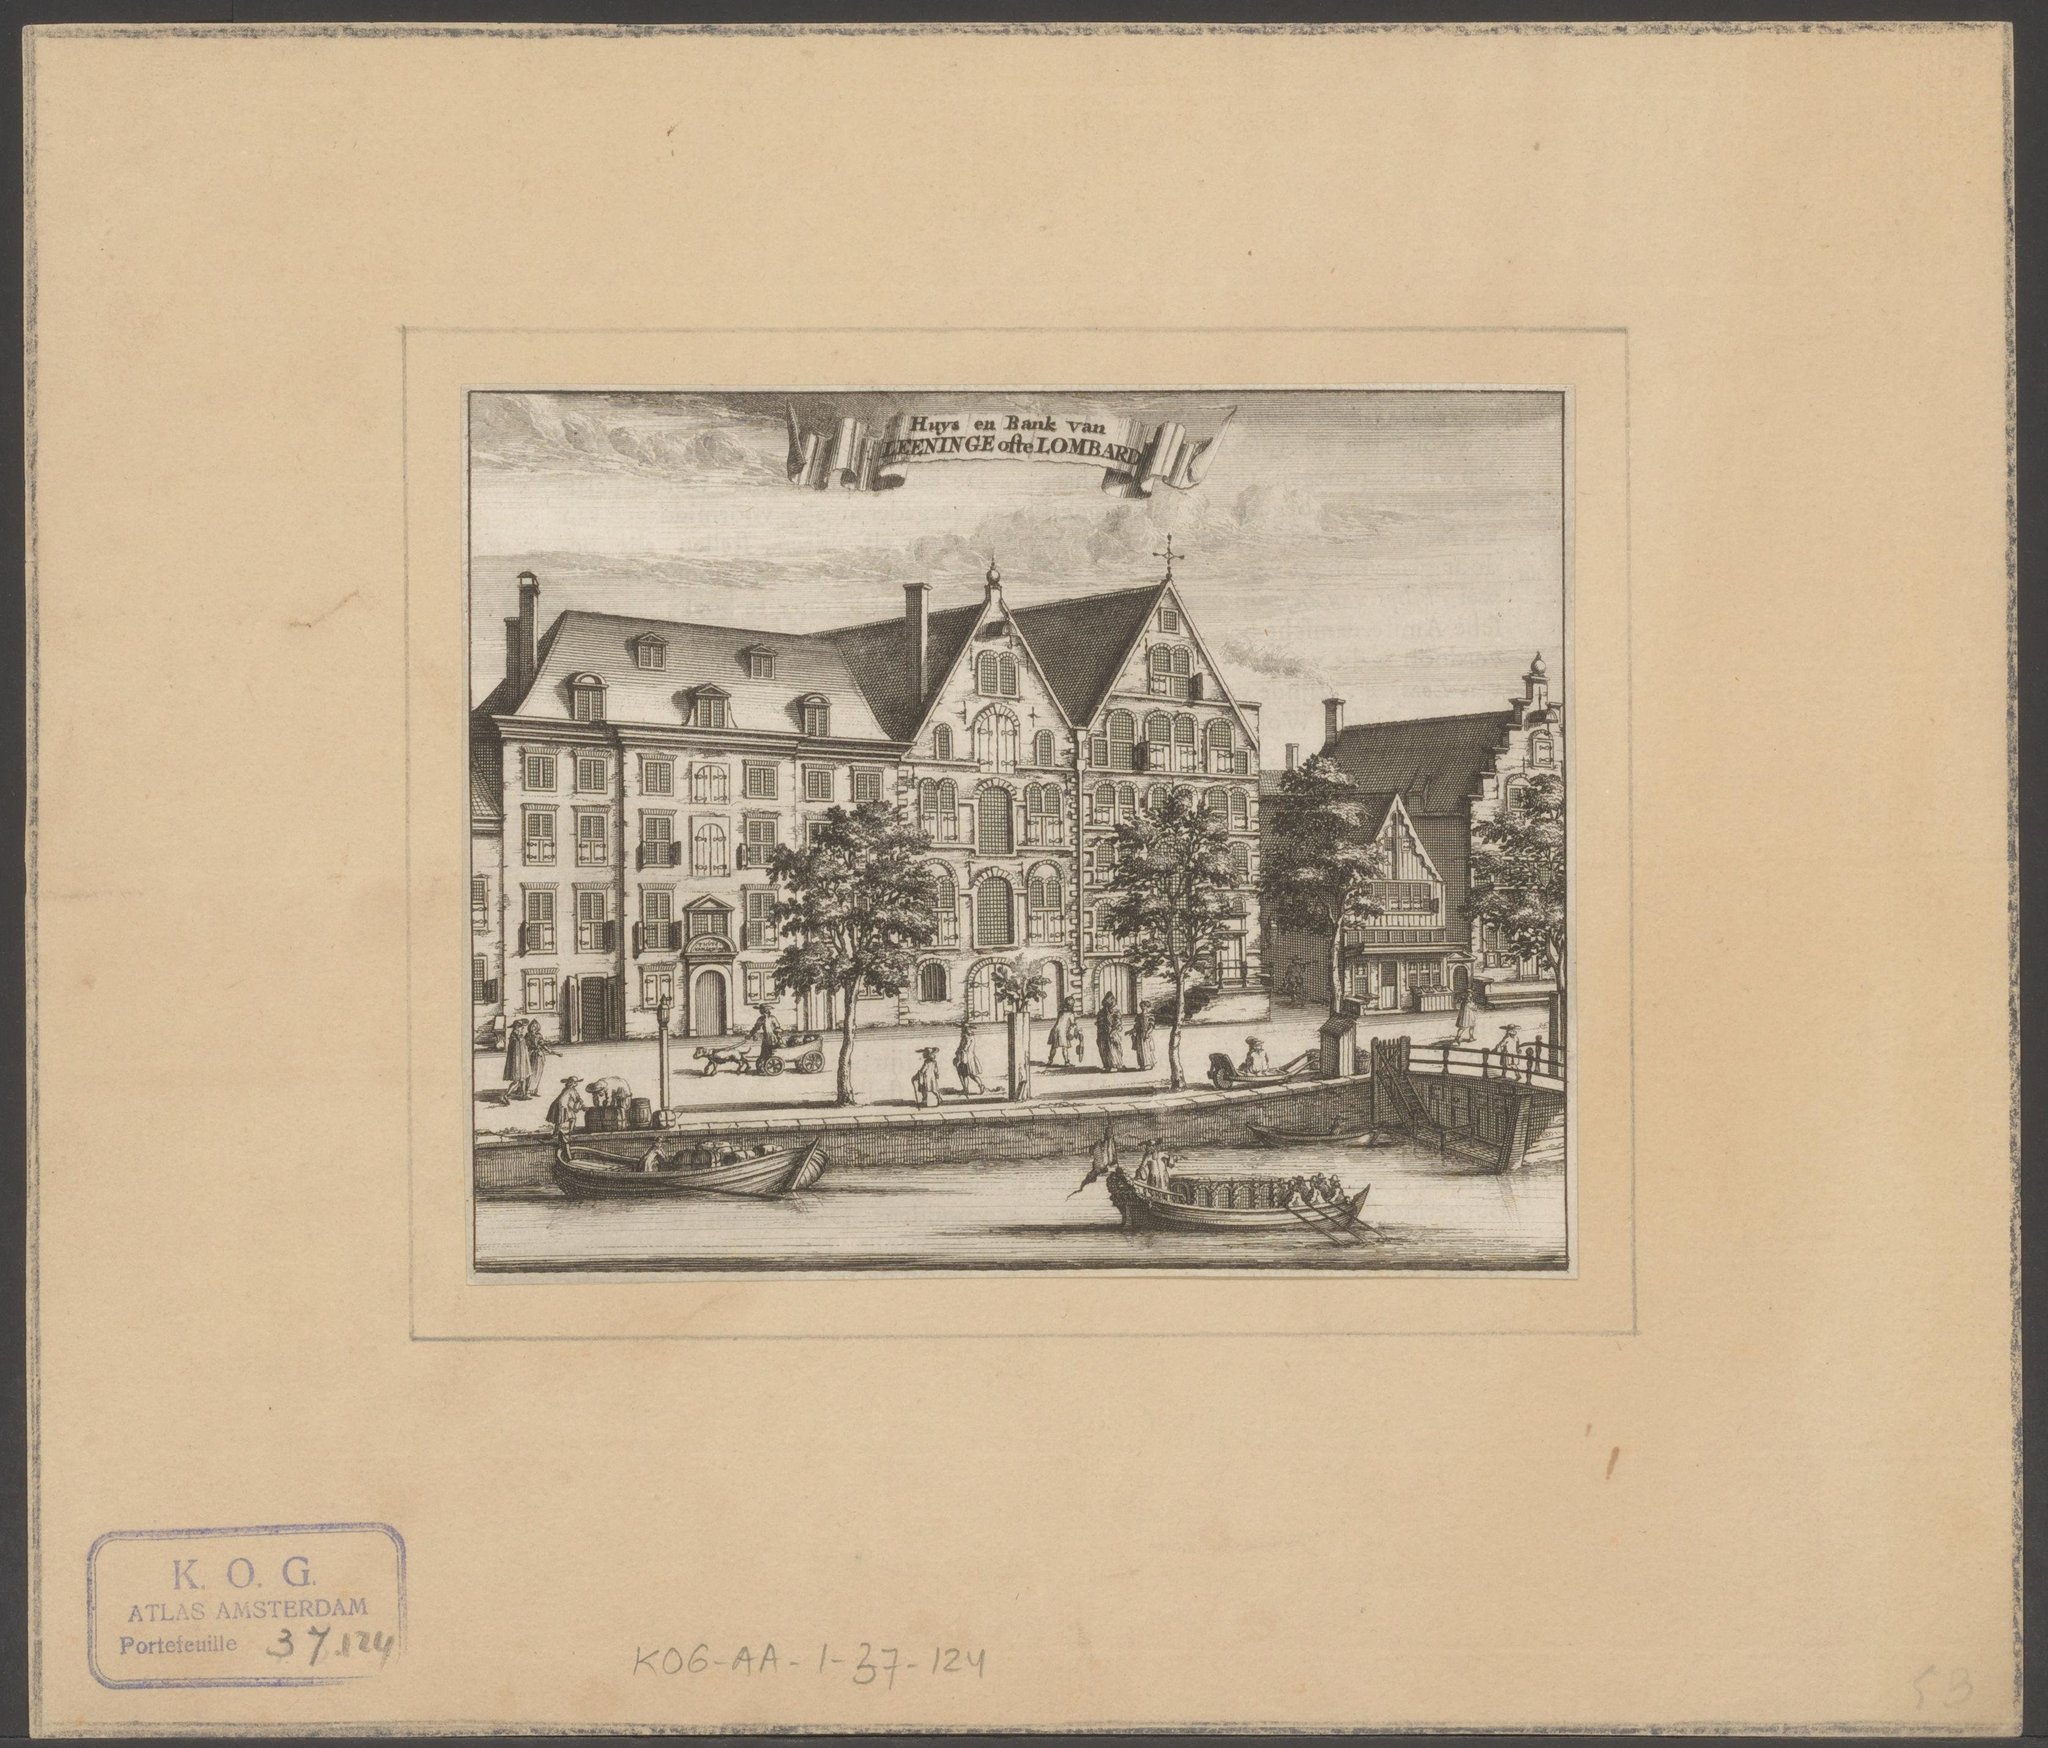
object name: print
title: Huys en Bank van Leeninge ofte Lombard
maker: Anonymous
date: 1693-1694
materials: paper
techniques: engraving, etching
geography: northern netherlands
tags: pawnbroker, lombard, rowing-boat, canoe, etc., bank, canals, waters (in city) (+ city(-scape) with figures, staffage)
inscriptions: collector's mark: Lugt 1641b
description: Huidige staat van prent ook gebruikt in: Commelin, Casparus. Beschryvinge van Amsterdam (…). Amsterdam: Abraham Wolfgang, Gillis Janssonius van Waesberge of Johannes Janssonius van Waesberge, Hendrick Boom of weduwe Dirk Boom, Abraham van Sanderen en Rembertus Goethals, 1693, dl. 2. En in: Commelin, Casparus. Beschryvinge van Amsterdam (…). Amsterdam: weduwe Aart Dircksz. Oossaan, 1694, dl. 2. Tweede staat van prent (met opgewerkte lucht- en waterpartijen) ook gebruikt in: Commelin, Casparus. Beschryvinge van Amsterdam (…). 2de druk. Amsterdam: Andries van Damme, Johannes Ratelband, weduwe Antony van Aeltwijk en Hermanus Uytwerf, 1726, dl. 2.